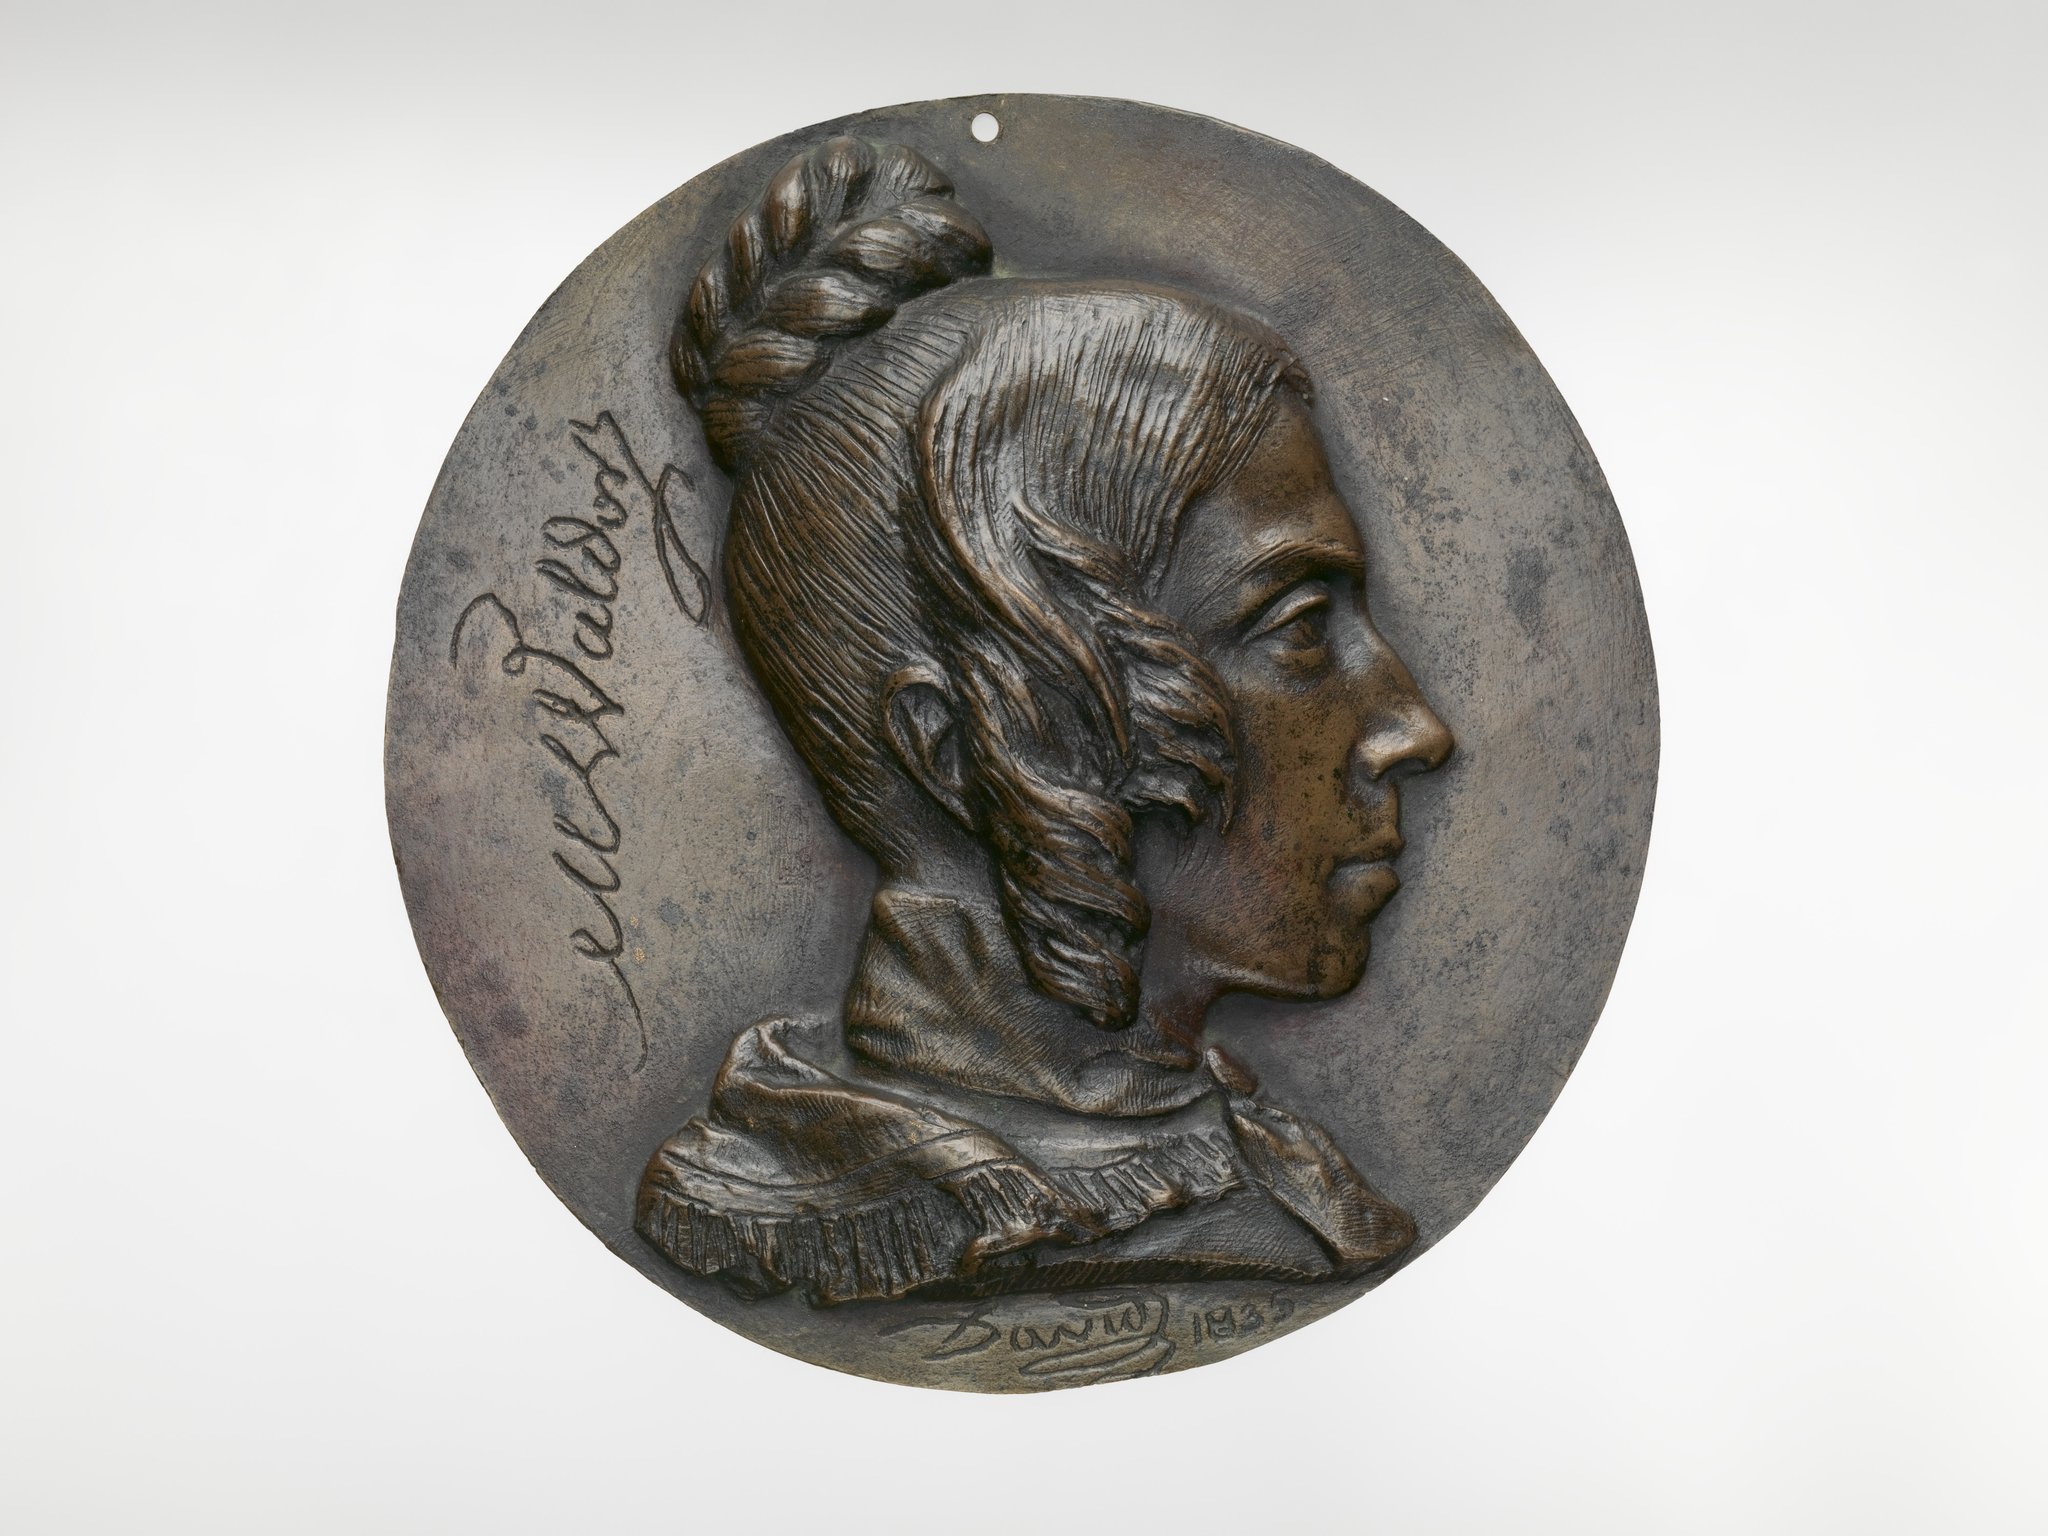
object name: medallion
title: Mélanie Waldor (1796–1871)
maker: pierre jean david d'angers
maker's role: maker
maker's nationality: french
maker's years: 1788-1856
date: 1835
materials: bronze, patina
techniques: casting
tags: profiles,women